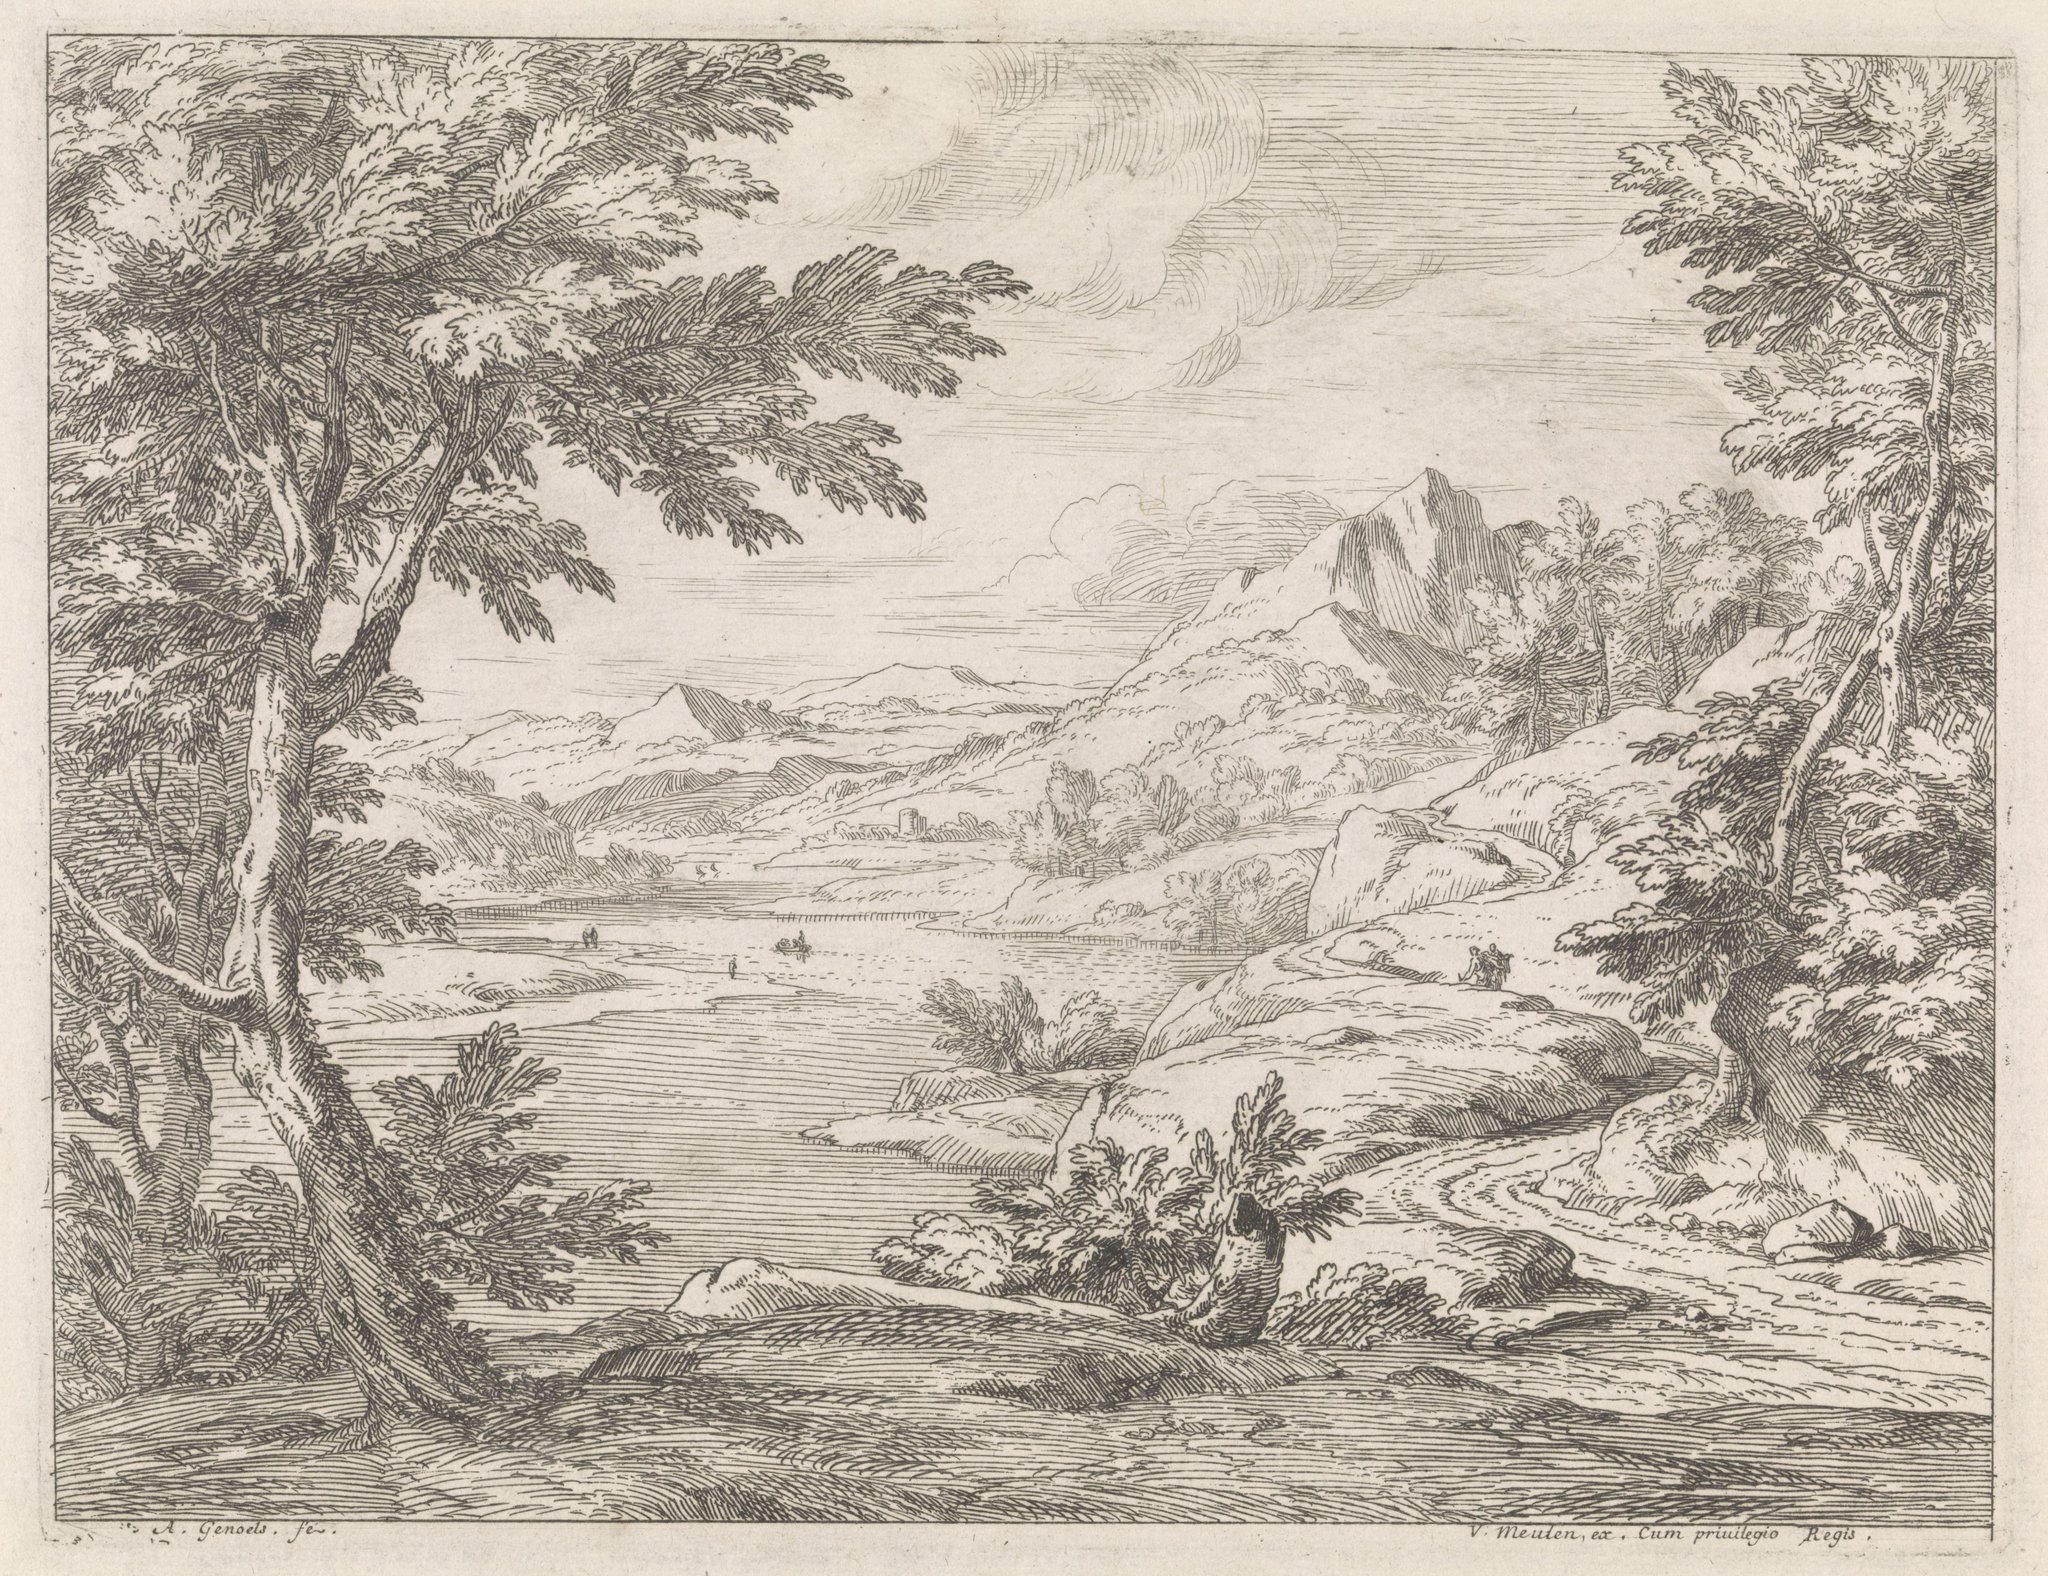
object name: print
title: Rivierlandschappen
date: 1650-1690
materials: paper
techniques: etching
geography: paris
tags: low hill country, river (+ landscape with figures, staffage), public road (+ city(-scape) with figures, staffage)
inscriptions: collector's mark: Lugt 240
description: Een heuvelachtig landschap met een rivier. Rechts naast de rivier een kronkelende weg. De prent maakt deel uit van een serie van rivierlandschappen.